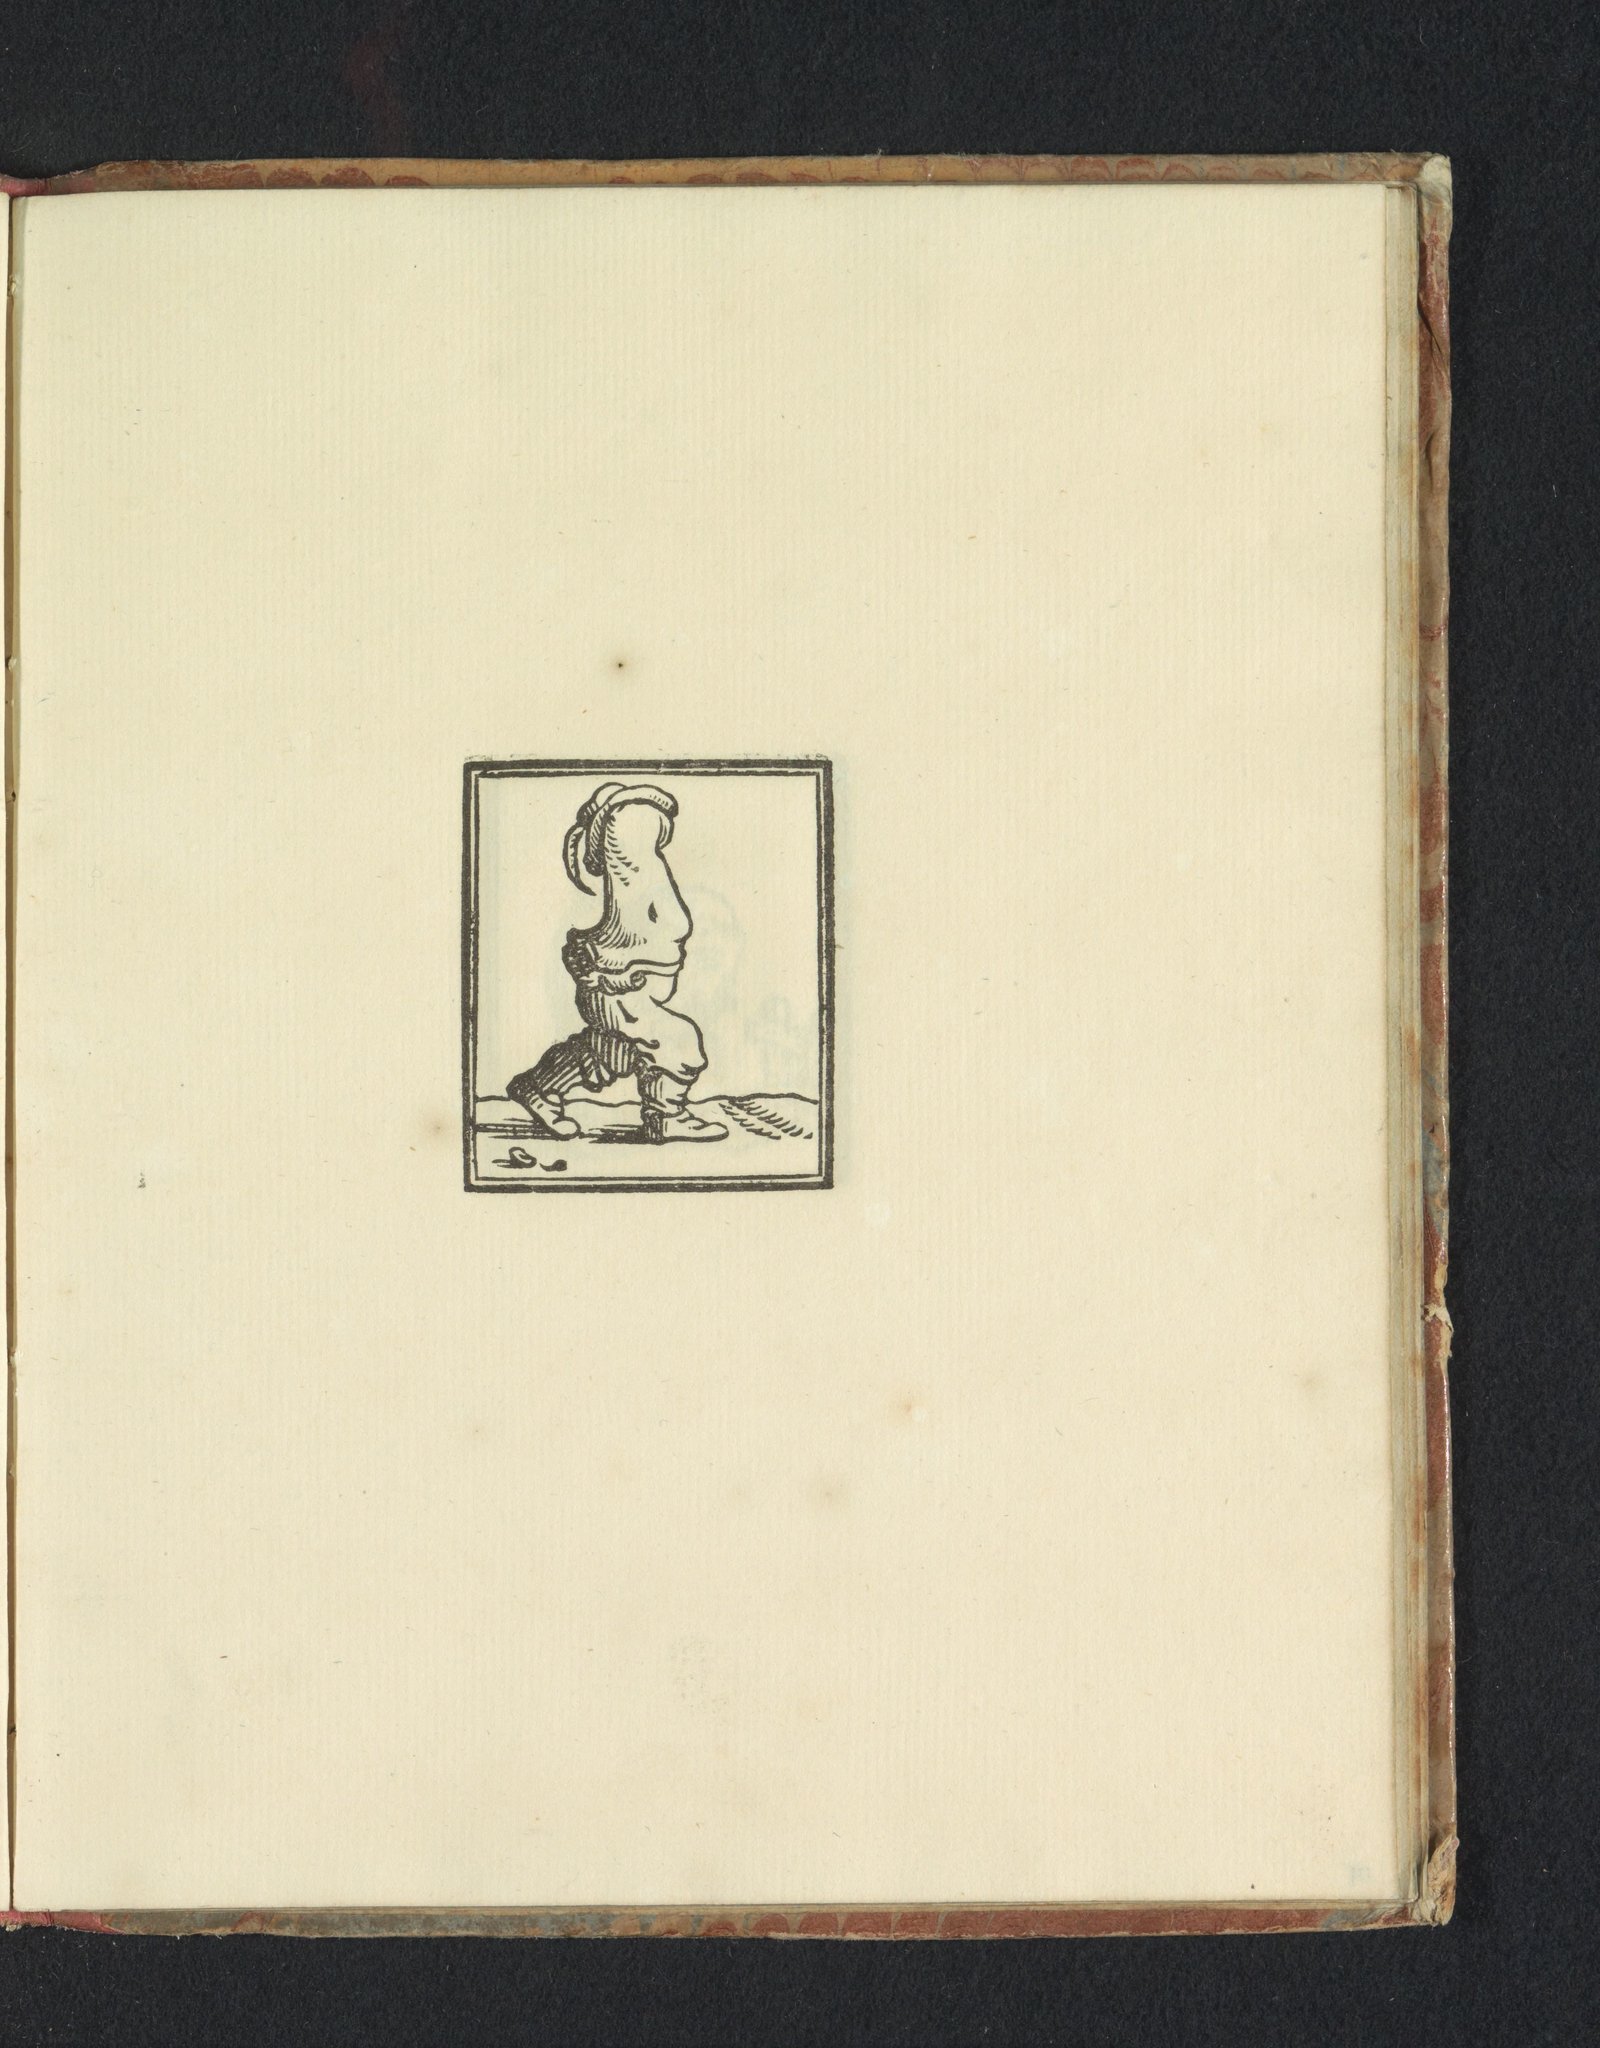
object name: print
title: Koot-jongen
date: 1731-1732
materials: paper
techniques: woodcut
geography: haarlem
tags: caricatures (human types)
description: Koddige figuur, in het onderschrift in de overzichtsprent draagt deze figuur de naam: Koot-jongen. Onderdeel van het boekje: XXXVI. aartige figuuren, geinventeert door Izaak van Ostade tot Haarlem [1731-1732].